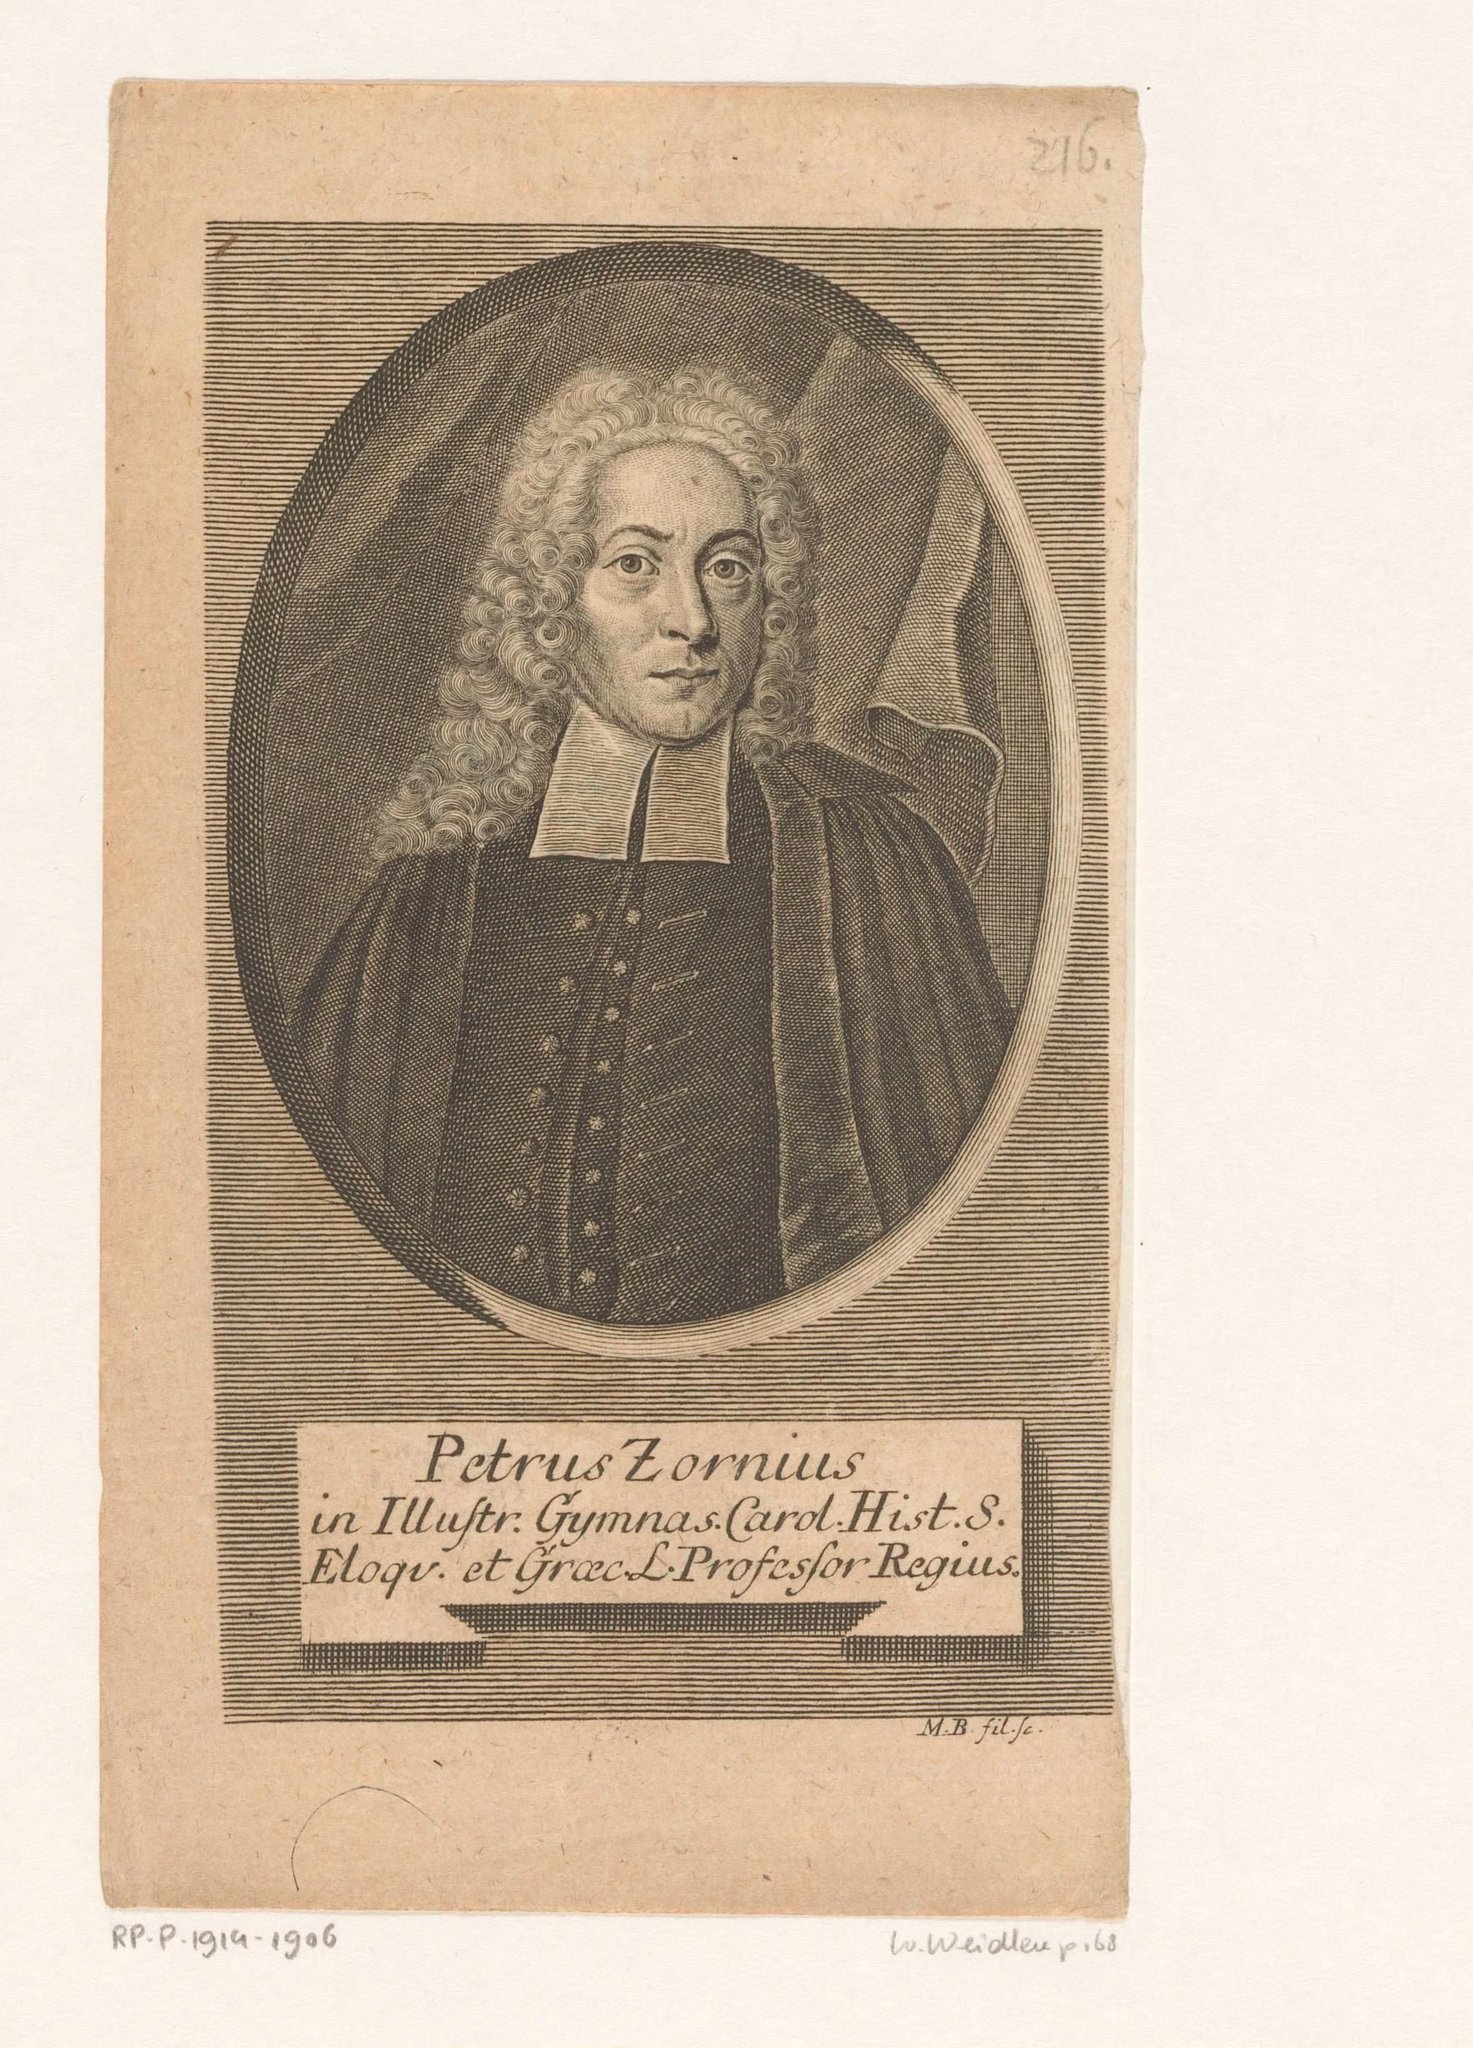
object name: print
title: Portret van Peter Zorn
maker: johann martin bernigeroth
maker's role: print maker, publisher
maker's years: 1713-1767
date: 1737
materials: paper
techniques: engraving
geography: leipzig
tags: berlin, historical persons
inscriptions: collector's mark: Lugt 2228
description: Prent ook gebruikt in: Deutsche Acta Eruditorum (...). dl. 216. Leipzig: Johann Gottlieb Gleditsch, 1737.